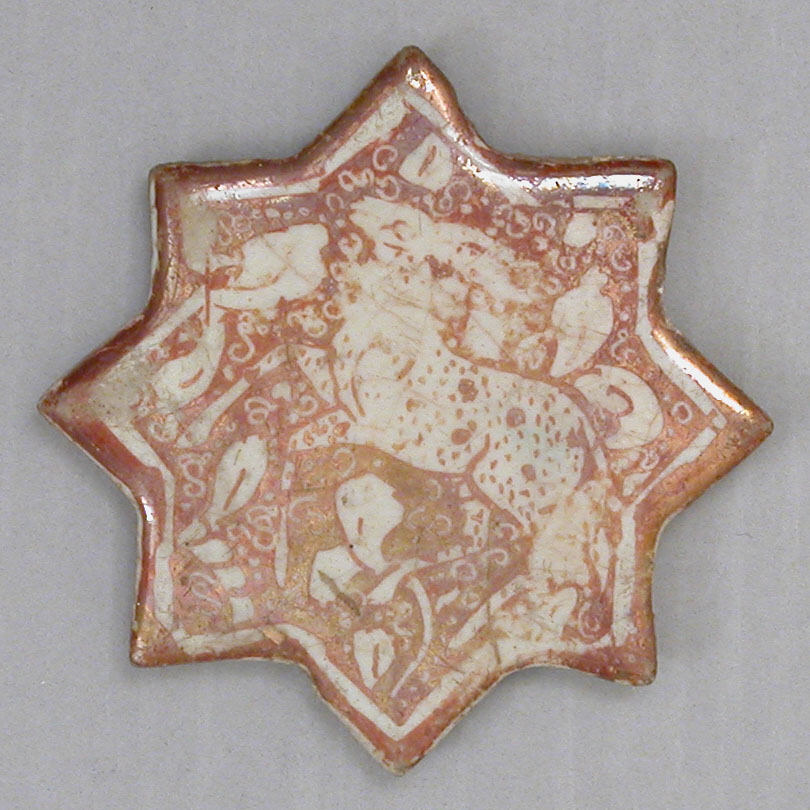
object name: tile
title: Star-Shaped Tile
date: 1201-1300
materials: stonepaste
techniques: luster painting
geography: iran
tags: deer